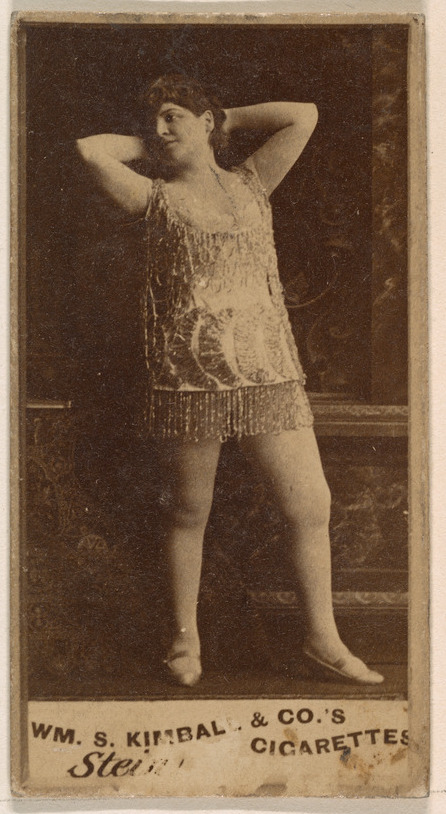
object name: photograph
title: Miss Stein, from the Actresses series (N203) issued by Wm. S. Kimball & Co.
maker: william s. kimball & company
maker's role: publisher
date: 1889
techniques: color lithograph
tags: portraits,women,actresses